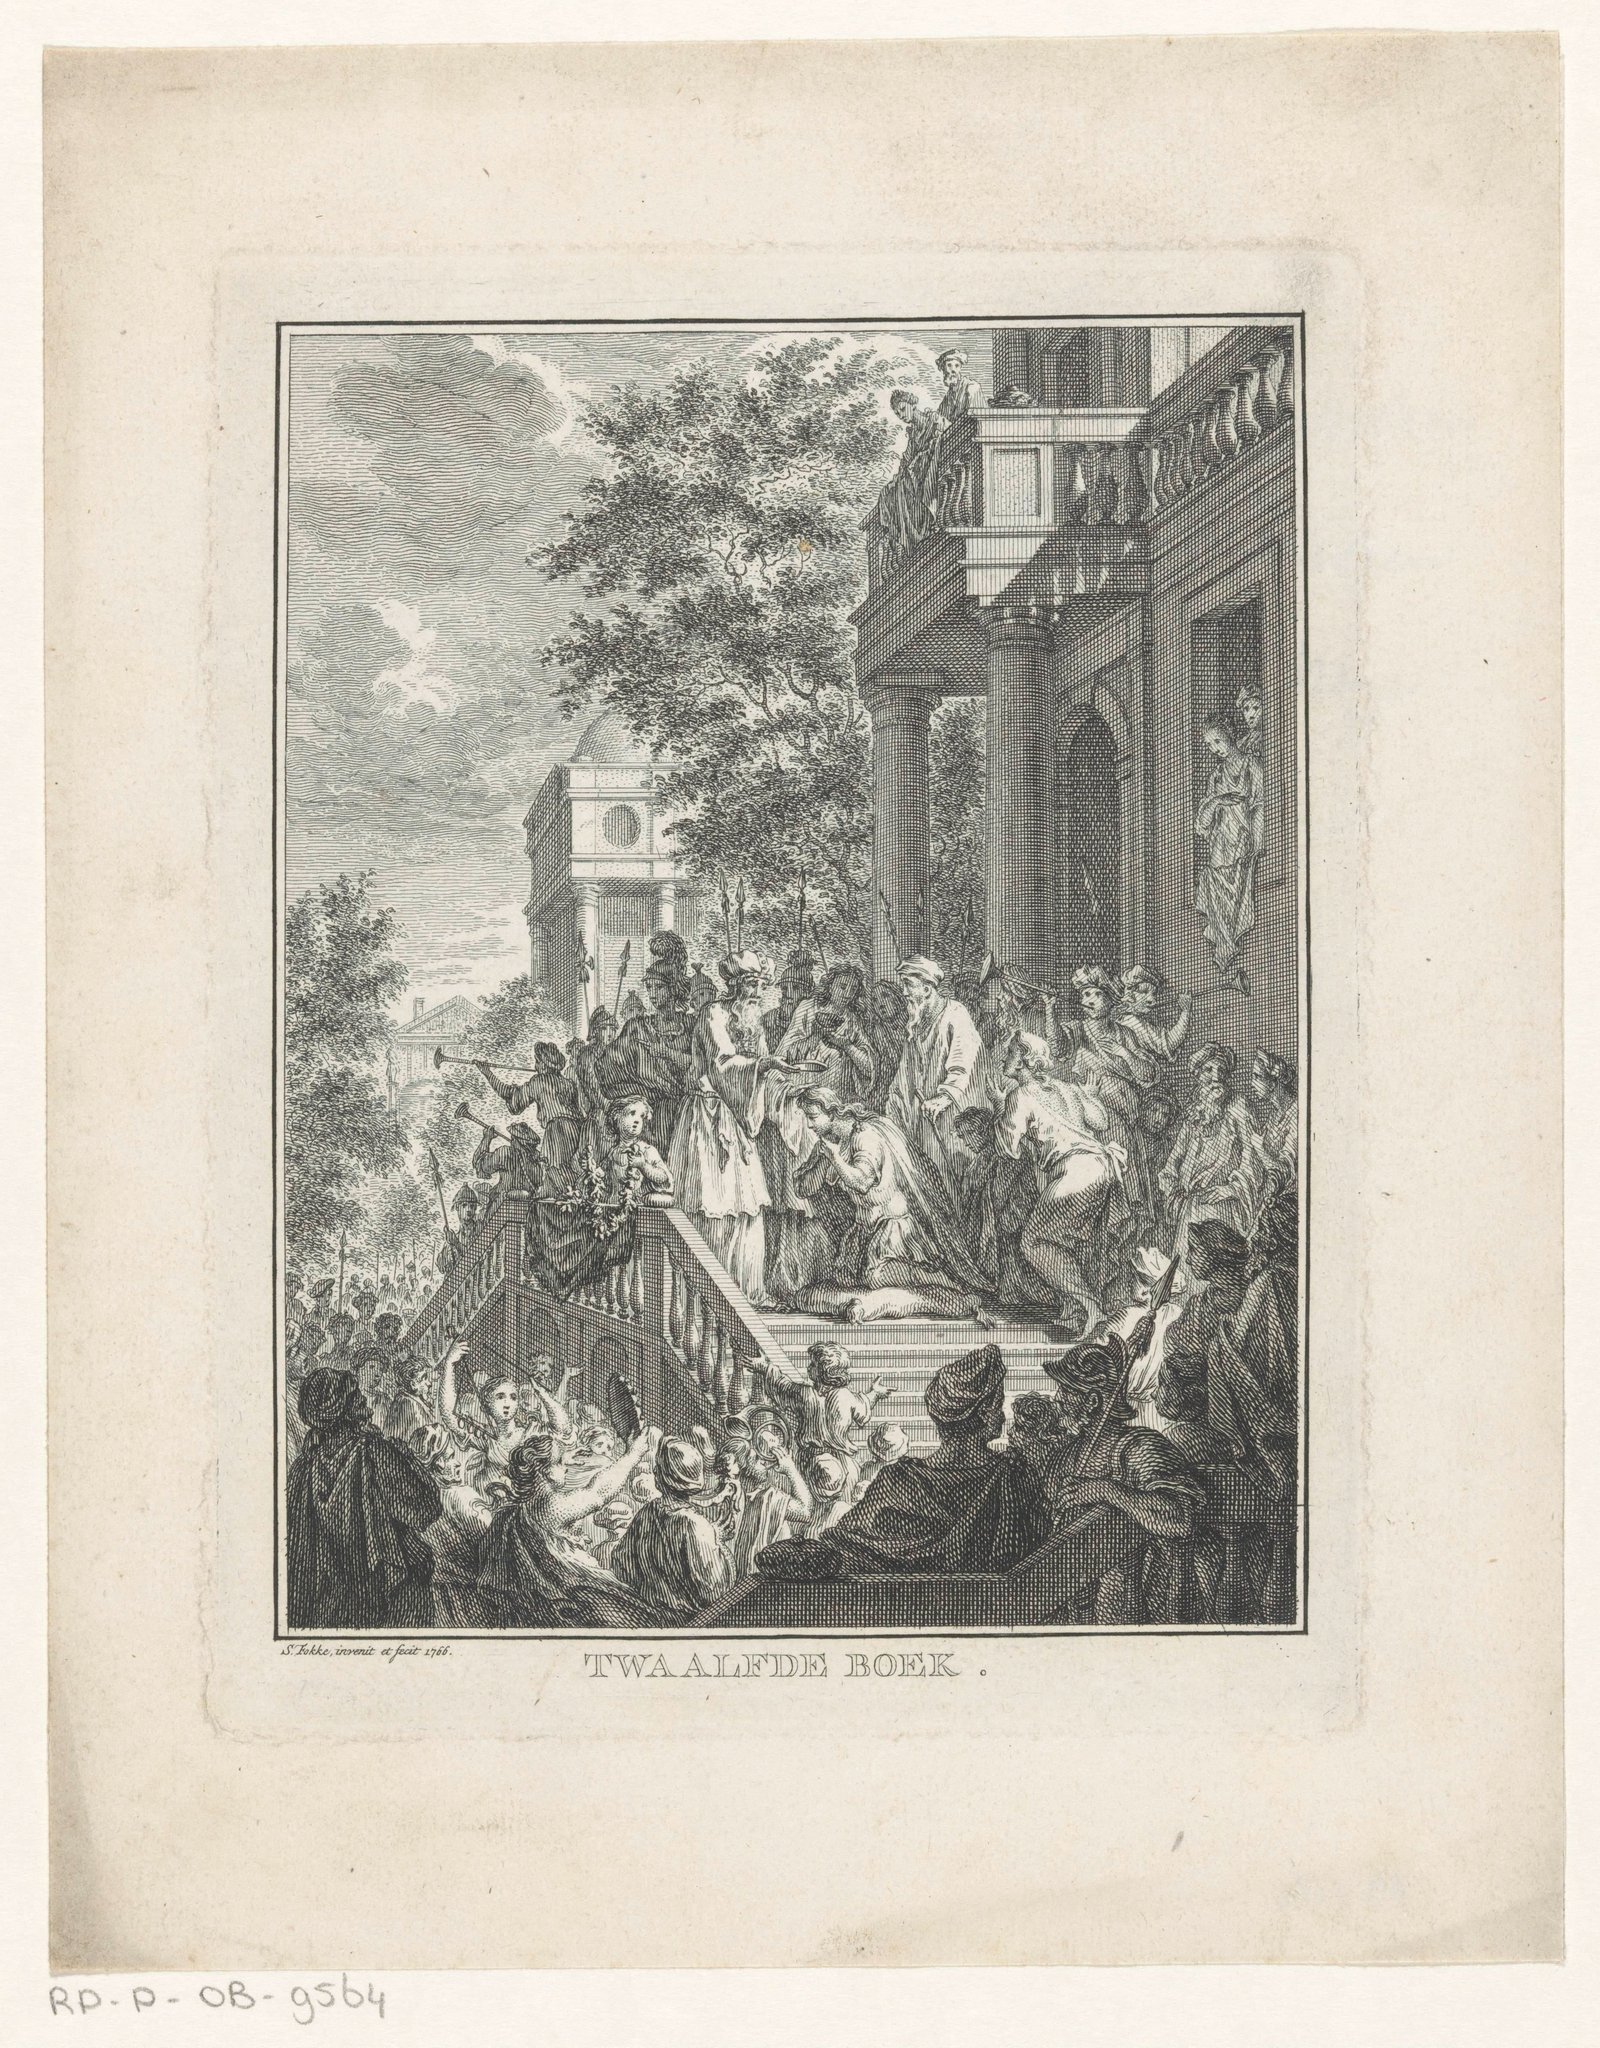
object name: print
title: Twaalfde Boek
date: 1766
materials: paper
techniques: etching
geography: amsterdam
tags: coronation of david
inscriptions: collector's mark: Lugt 2228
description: David is neergeknield op een kussen en wordt onder luid trompetgeschal op het bordes te Hebron gekroond. Een menigte mensen woont de kroning bij.